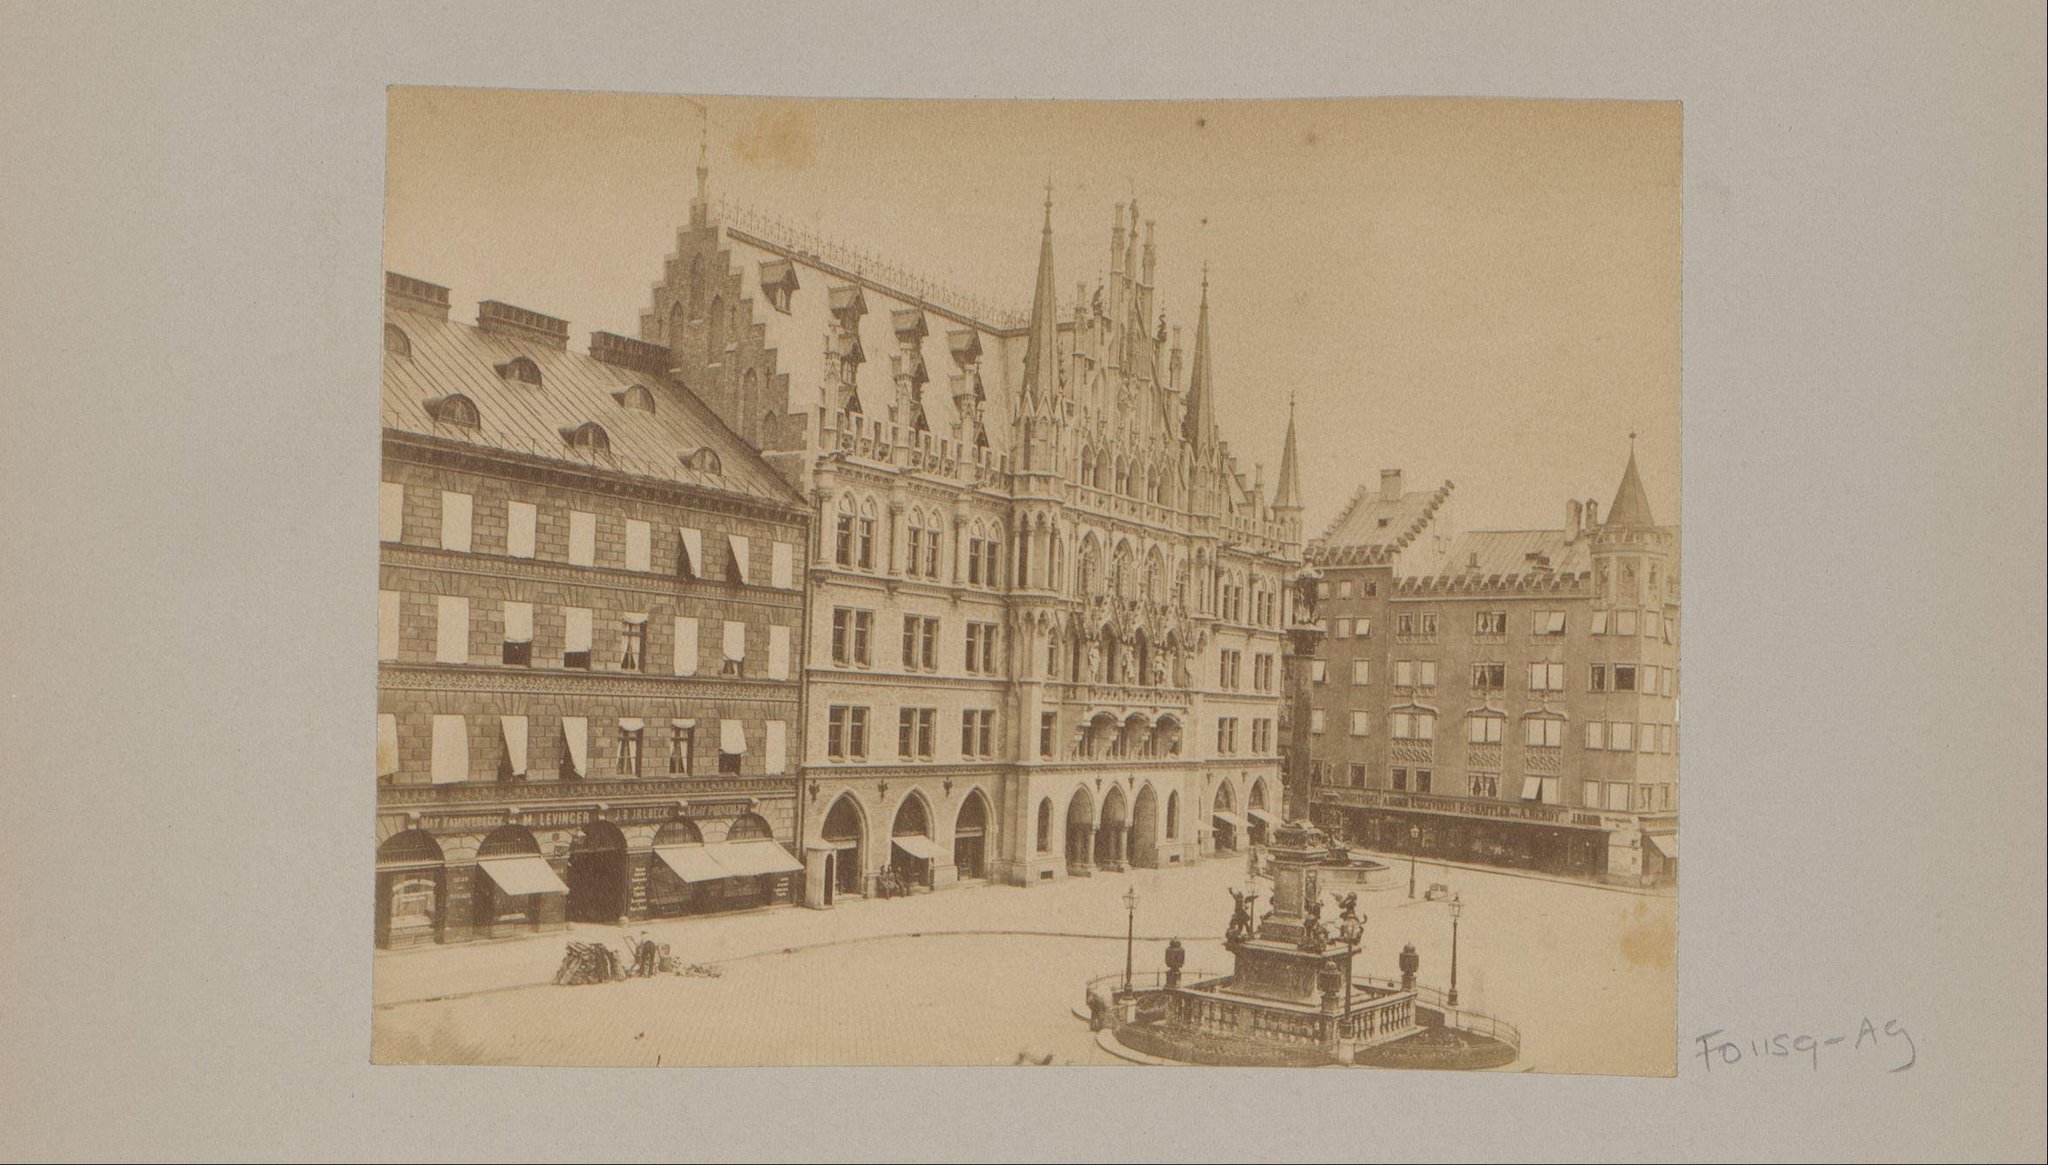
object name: photograph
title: Gezicht op Marienplatz met het Neues Rathaus in München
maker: Anonymous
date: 1880-1900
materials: photographic support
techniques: albumen print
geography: munich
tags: townhall, market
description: Onderdeel van Reisalbum met opnames van bezienswaardigheden in Zweden, Noorwegen, Denemarken, Beieren, Milaan en Parijs.